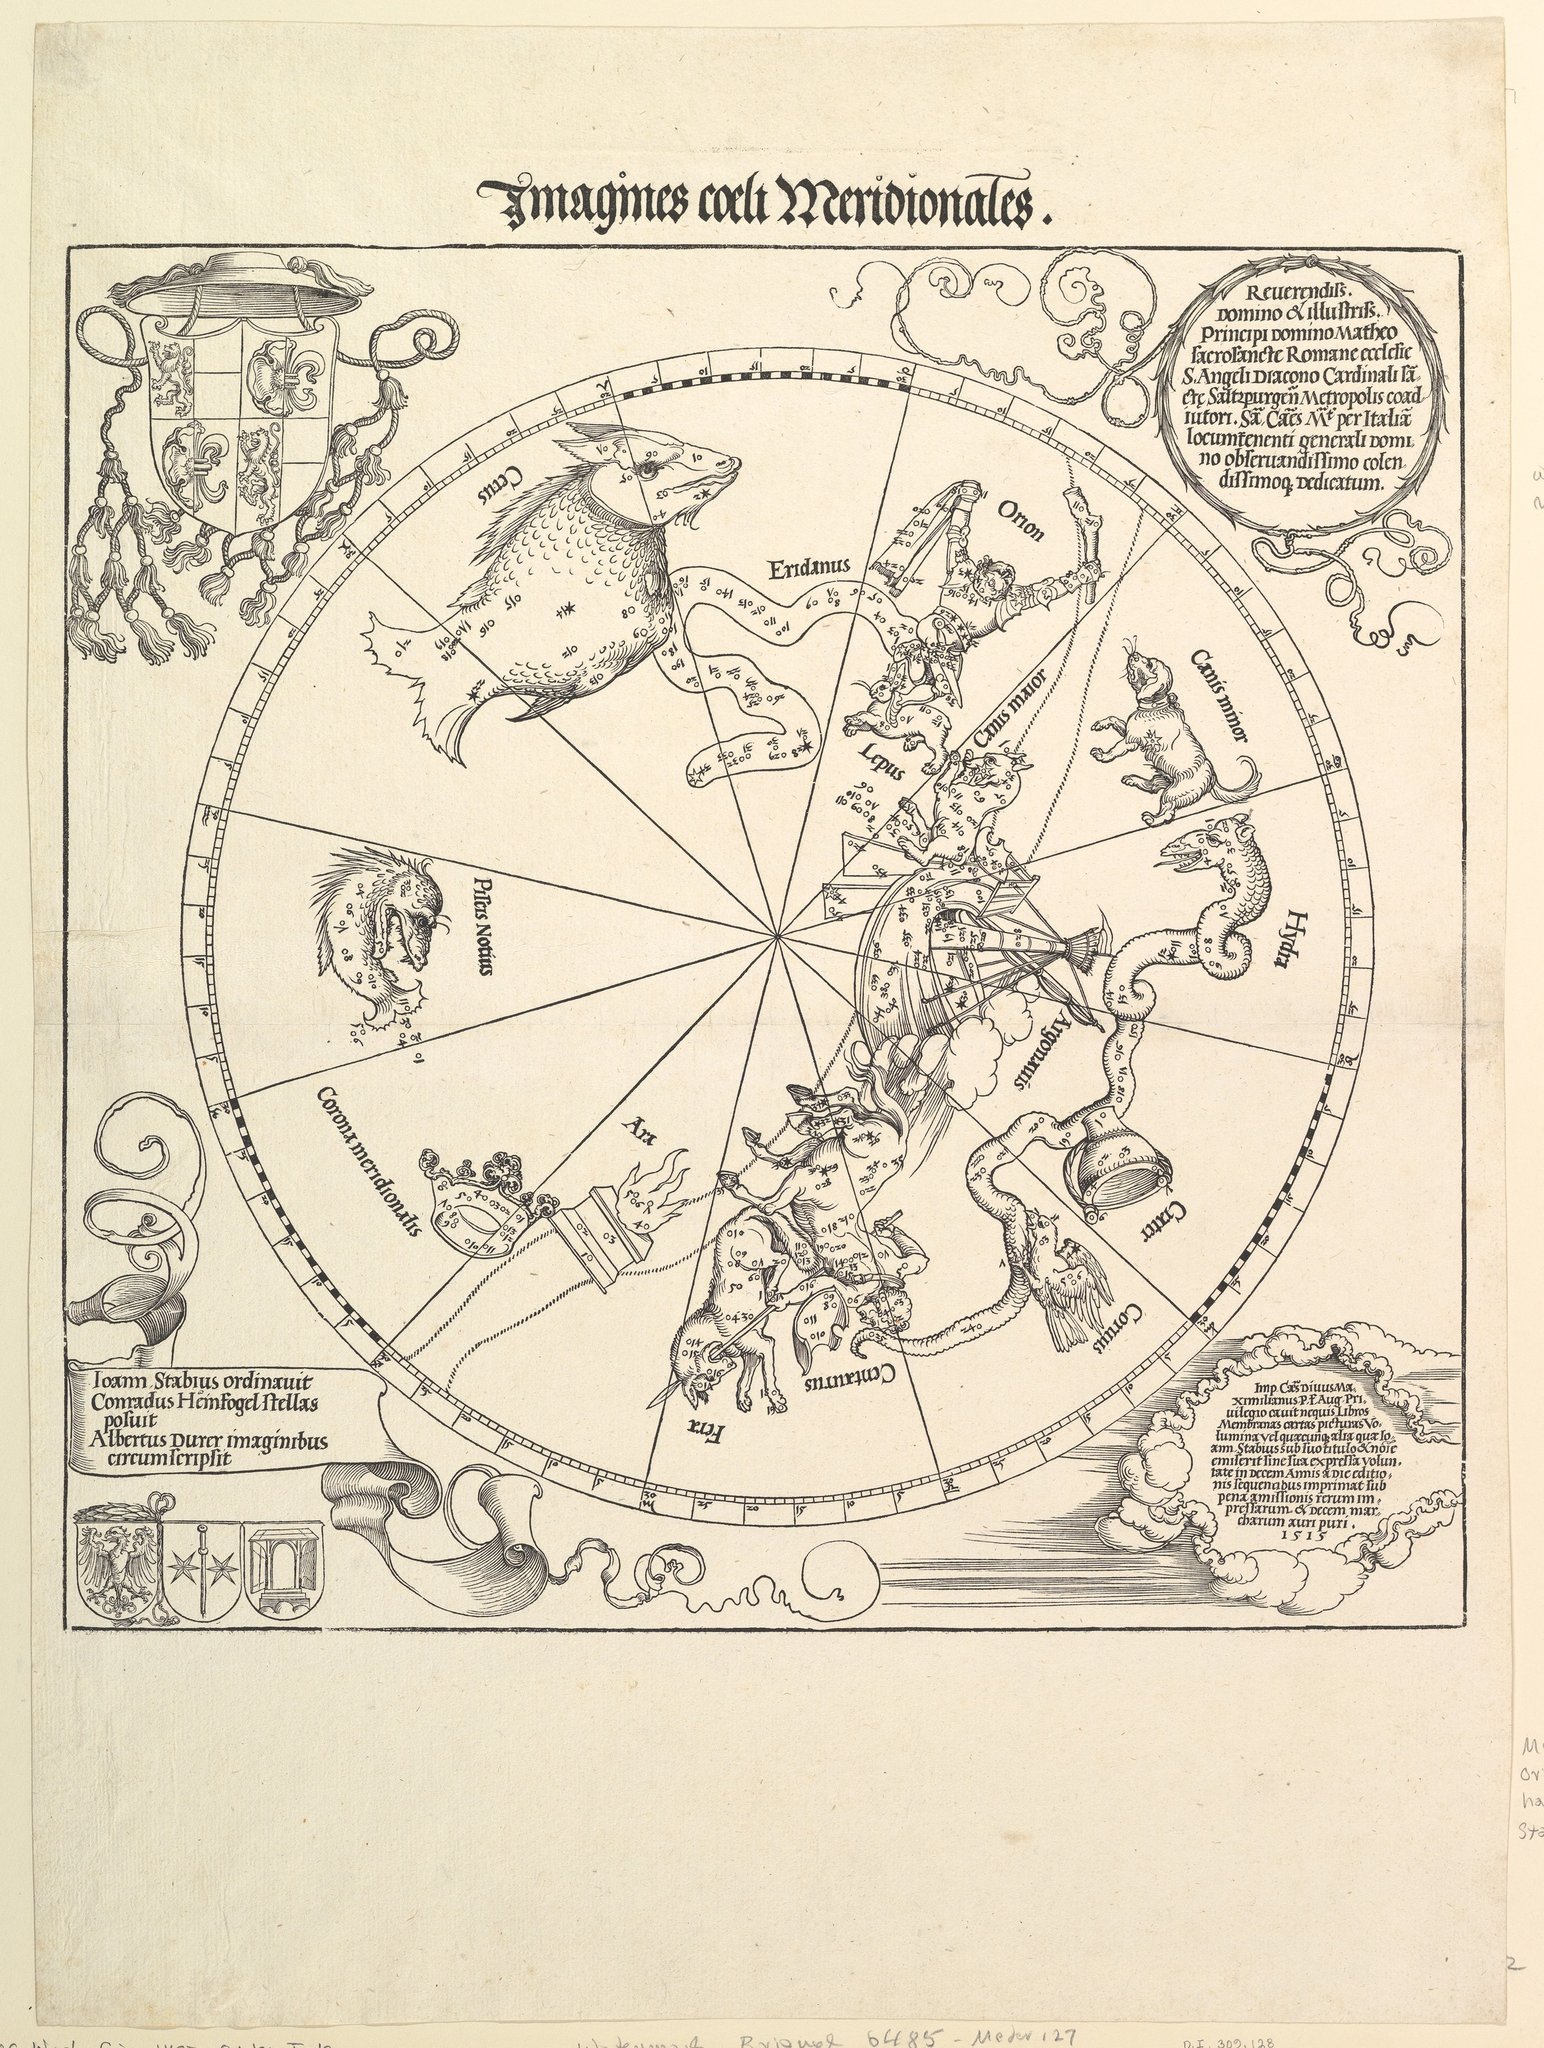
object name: print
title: The Celestial Globe-Southern Hemisphere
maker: albrecht dürer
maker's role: artist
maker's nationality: german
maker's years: 1471-1528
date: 1515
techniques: woodcut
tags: astronomy,coat of arms,maps